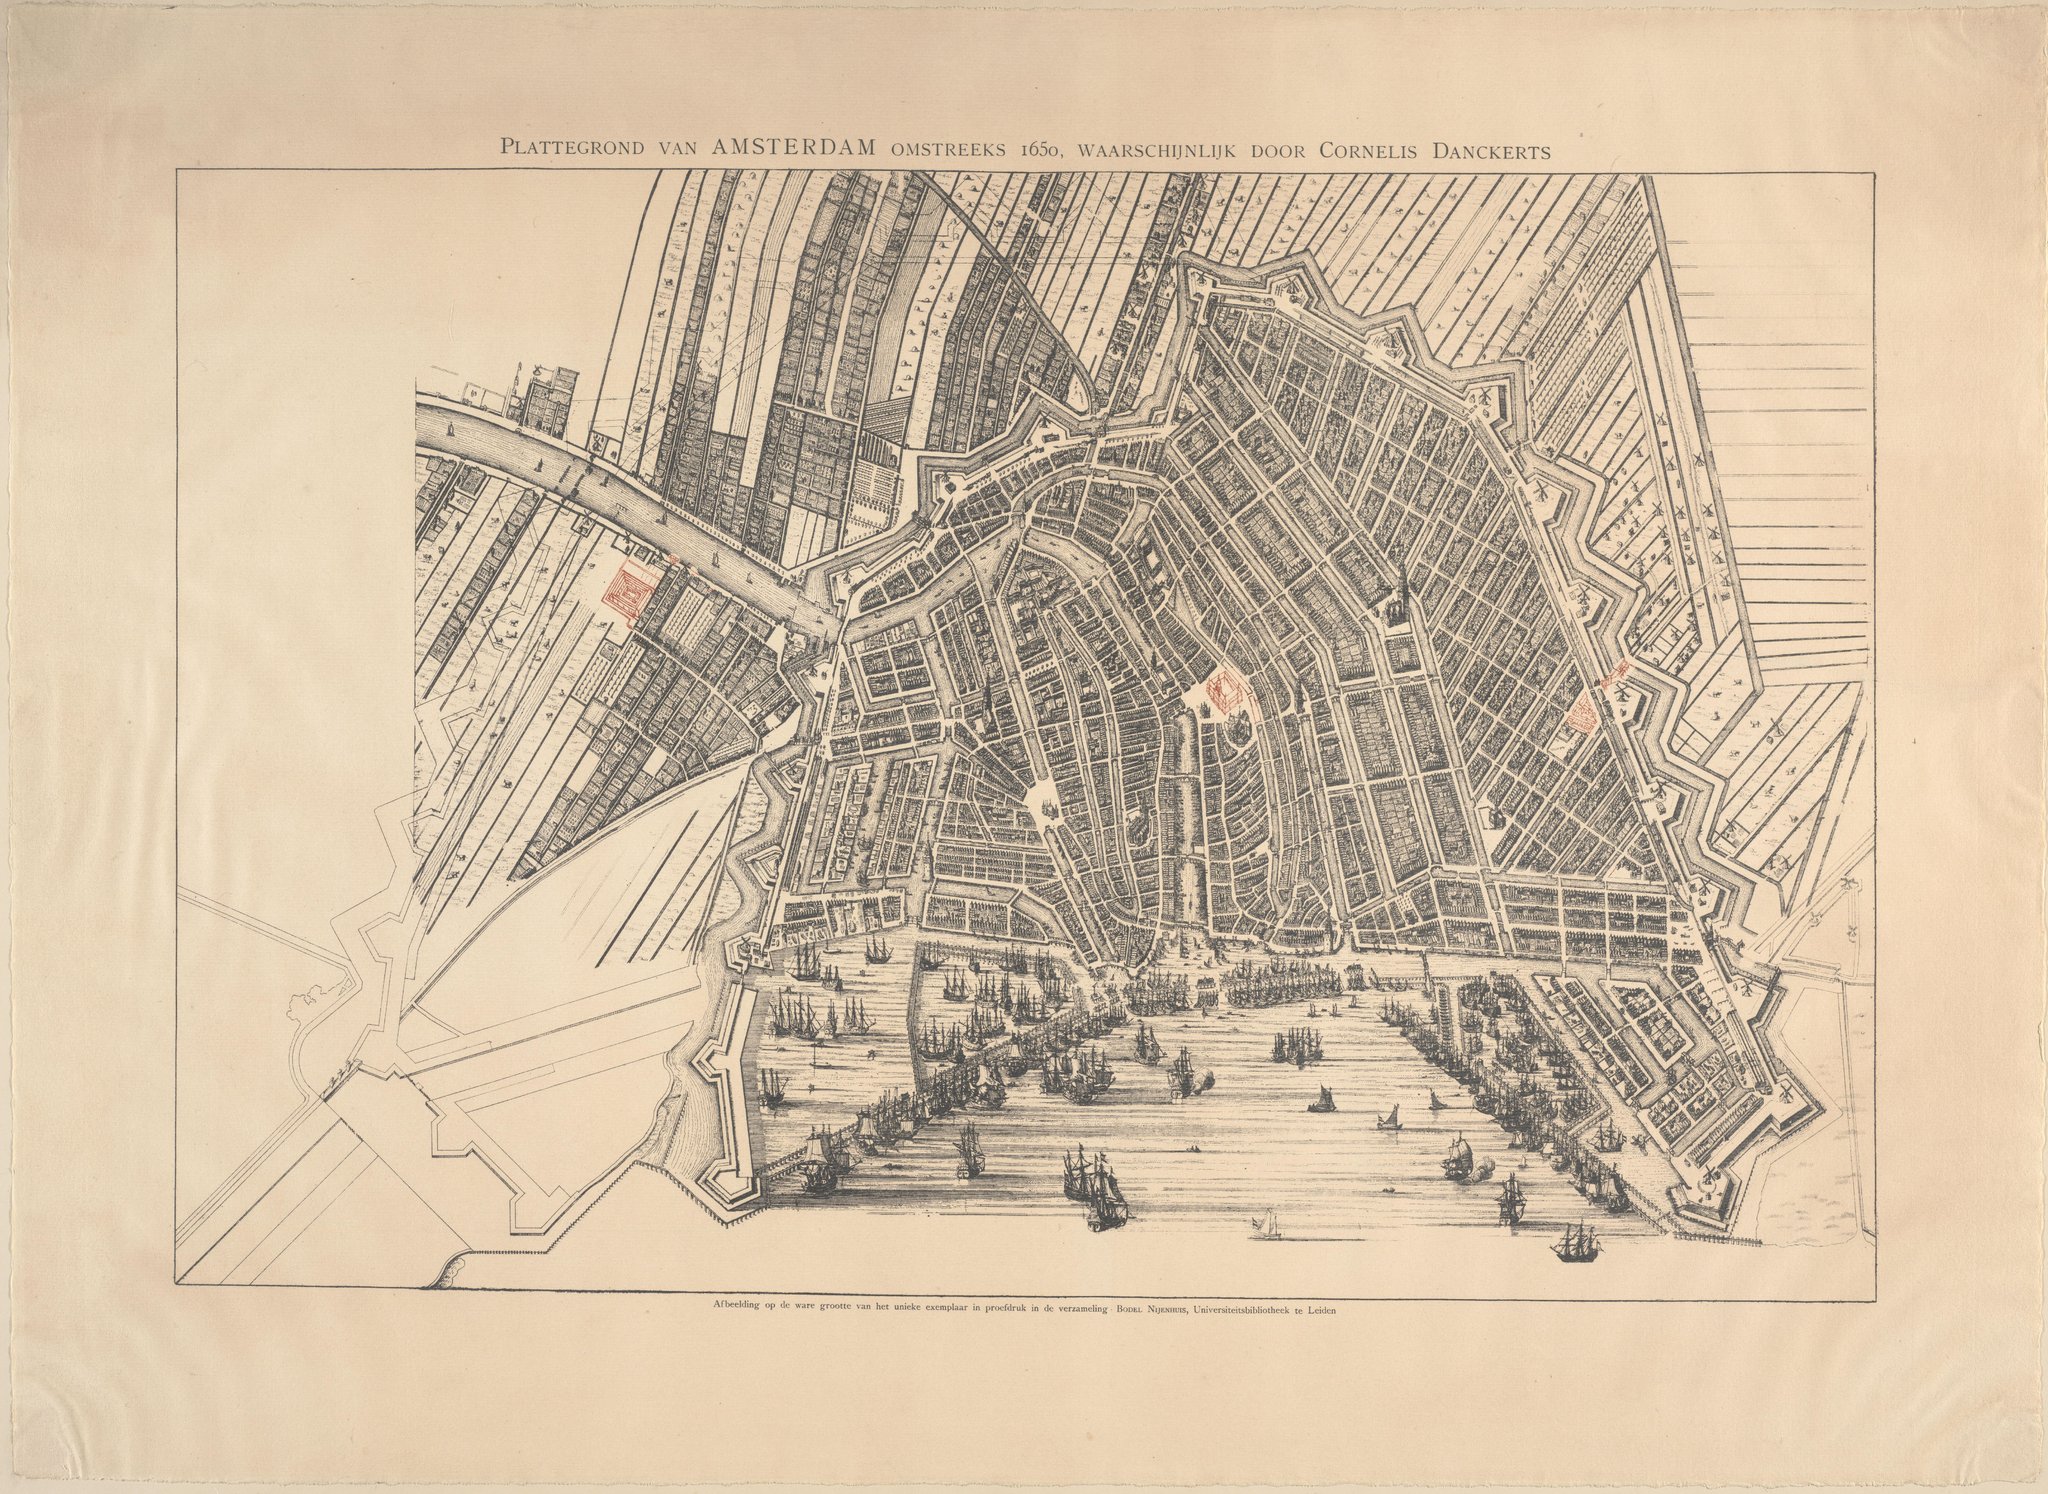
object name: print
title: Plattegrond van Amsterdam omstreeks 1650, waarschijnlijk door Cornelis Danckerts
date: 1915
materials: paper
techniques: lithograph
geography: amsterdam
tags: maps of cities, amsterdam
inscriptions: collector's mark: Lugt 1641b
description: Prent mogelijk uit: Lugt, Frits. Wandelingen met Rembrandt in en om Amsterdam. Amsterdam: P.N. van Kampen & Zoon, 1915.